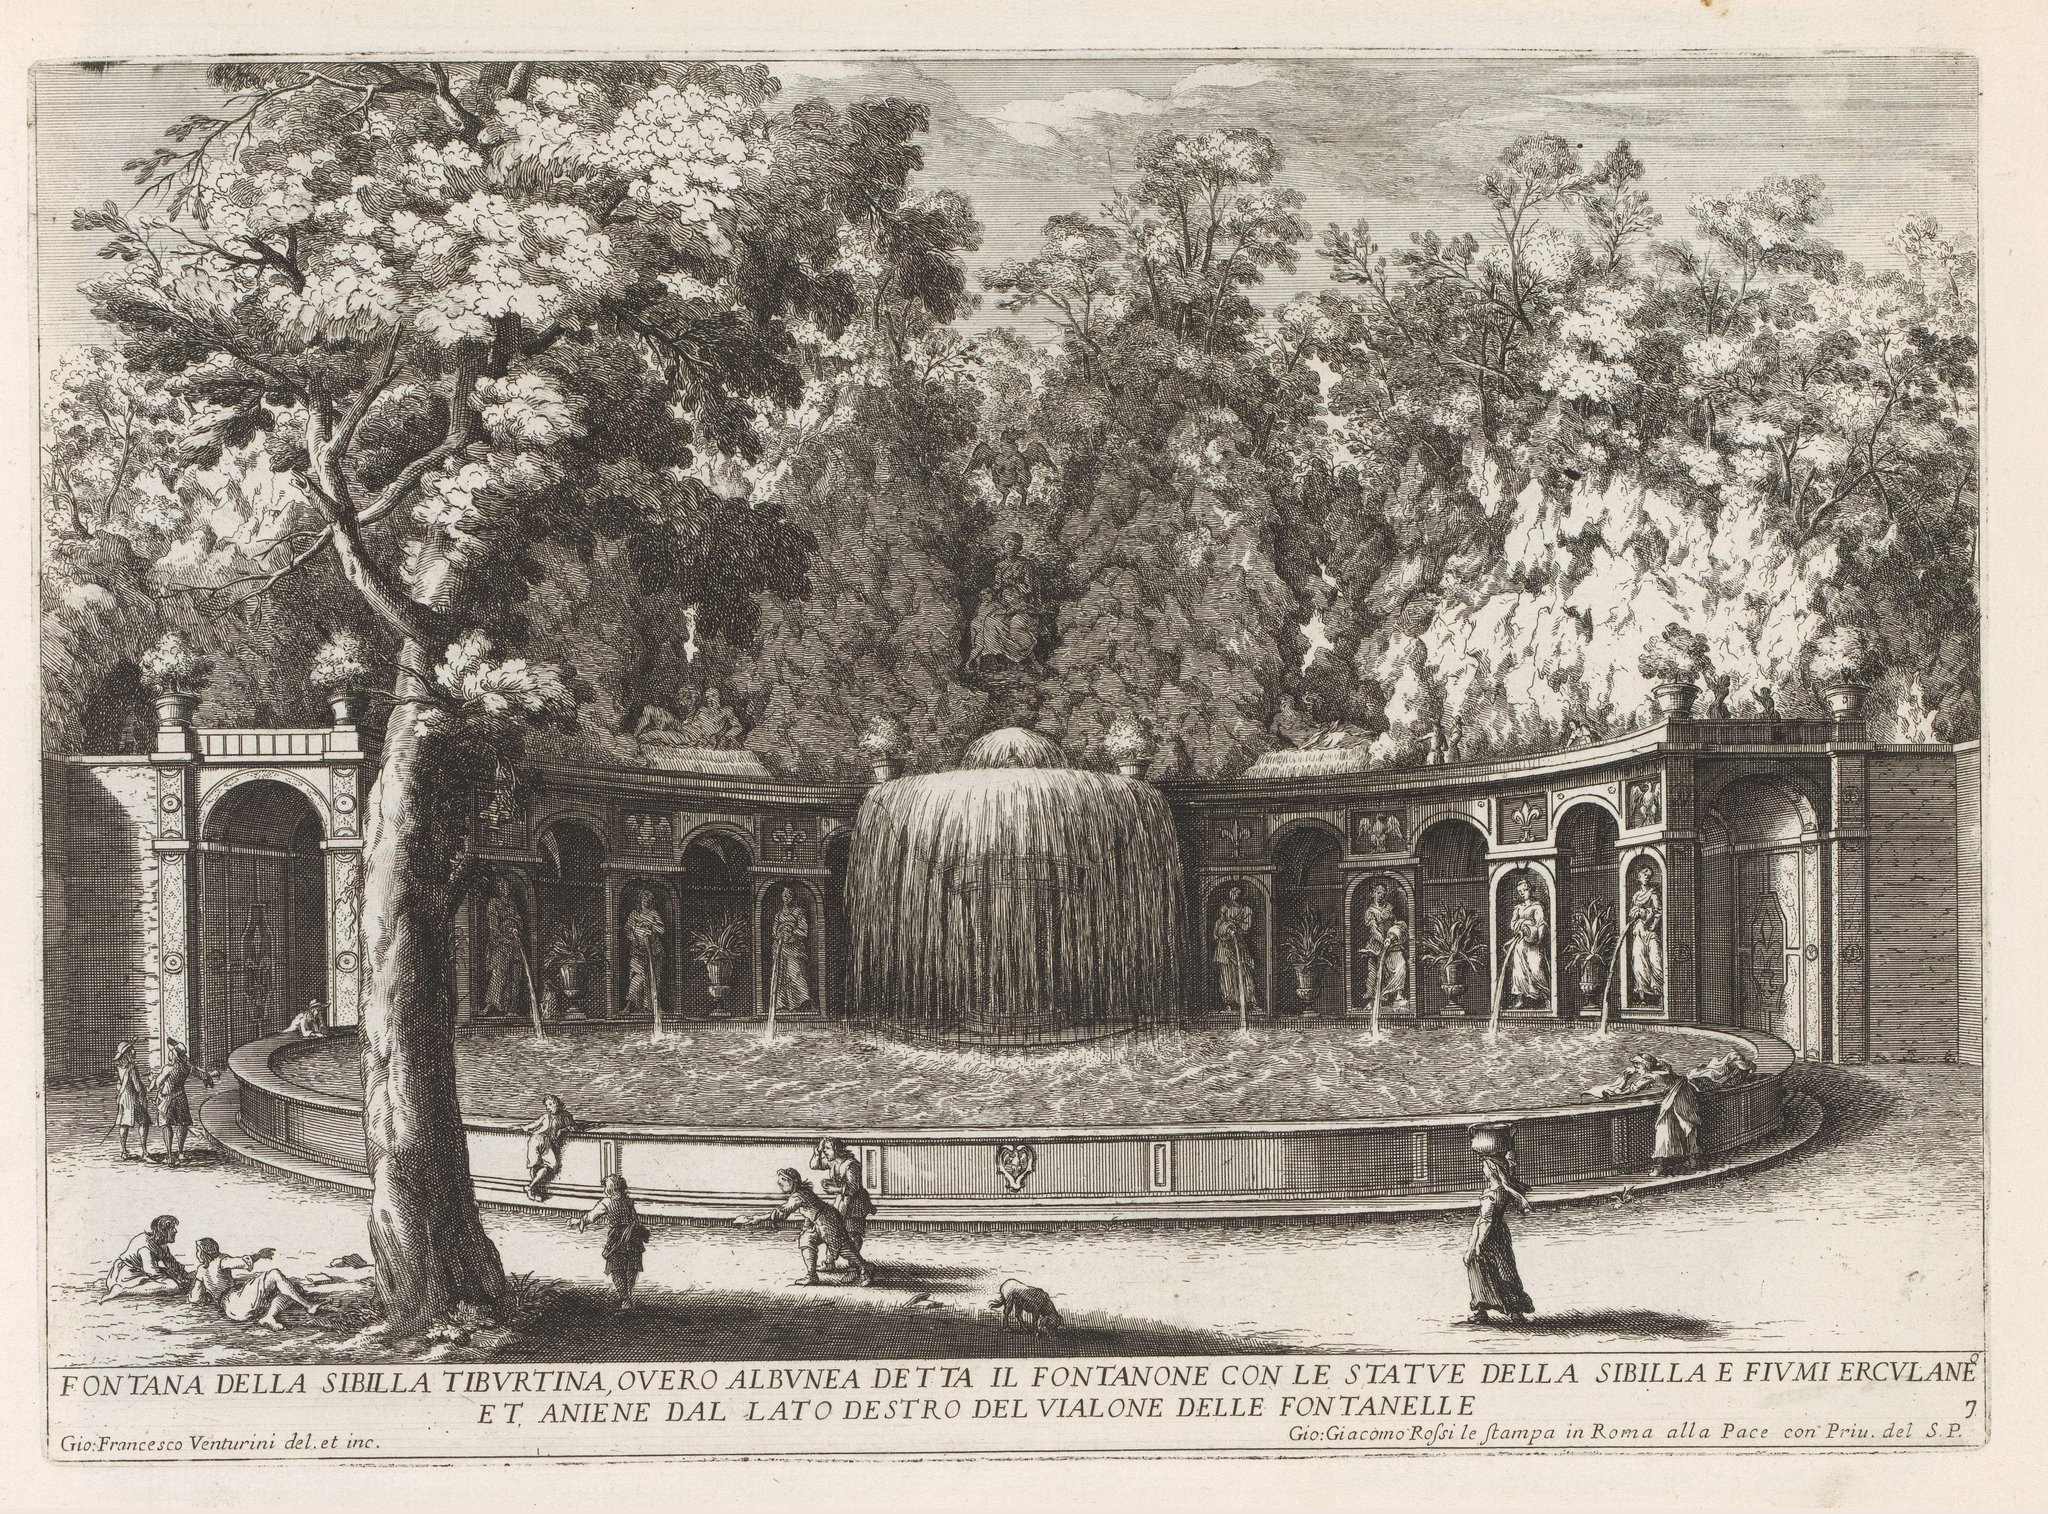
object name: album leaf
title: Le fontane del giardino Estense in Tivoli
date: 1653-1691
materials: paper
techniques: etching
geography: italy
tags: garden, sibyls, ornamental fountain, tivoli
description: Fontein met een ovaalvormig bassin. Boven de fontein een sculptuur van de Tiburtijnse Sibille. Genummerd rechtsonder: 7. De prent maakt deel uit van een album.